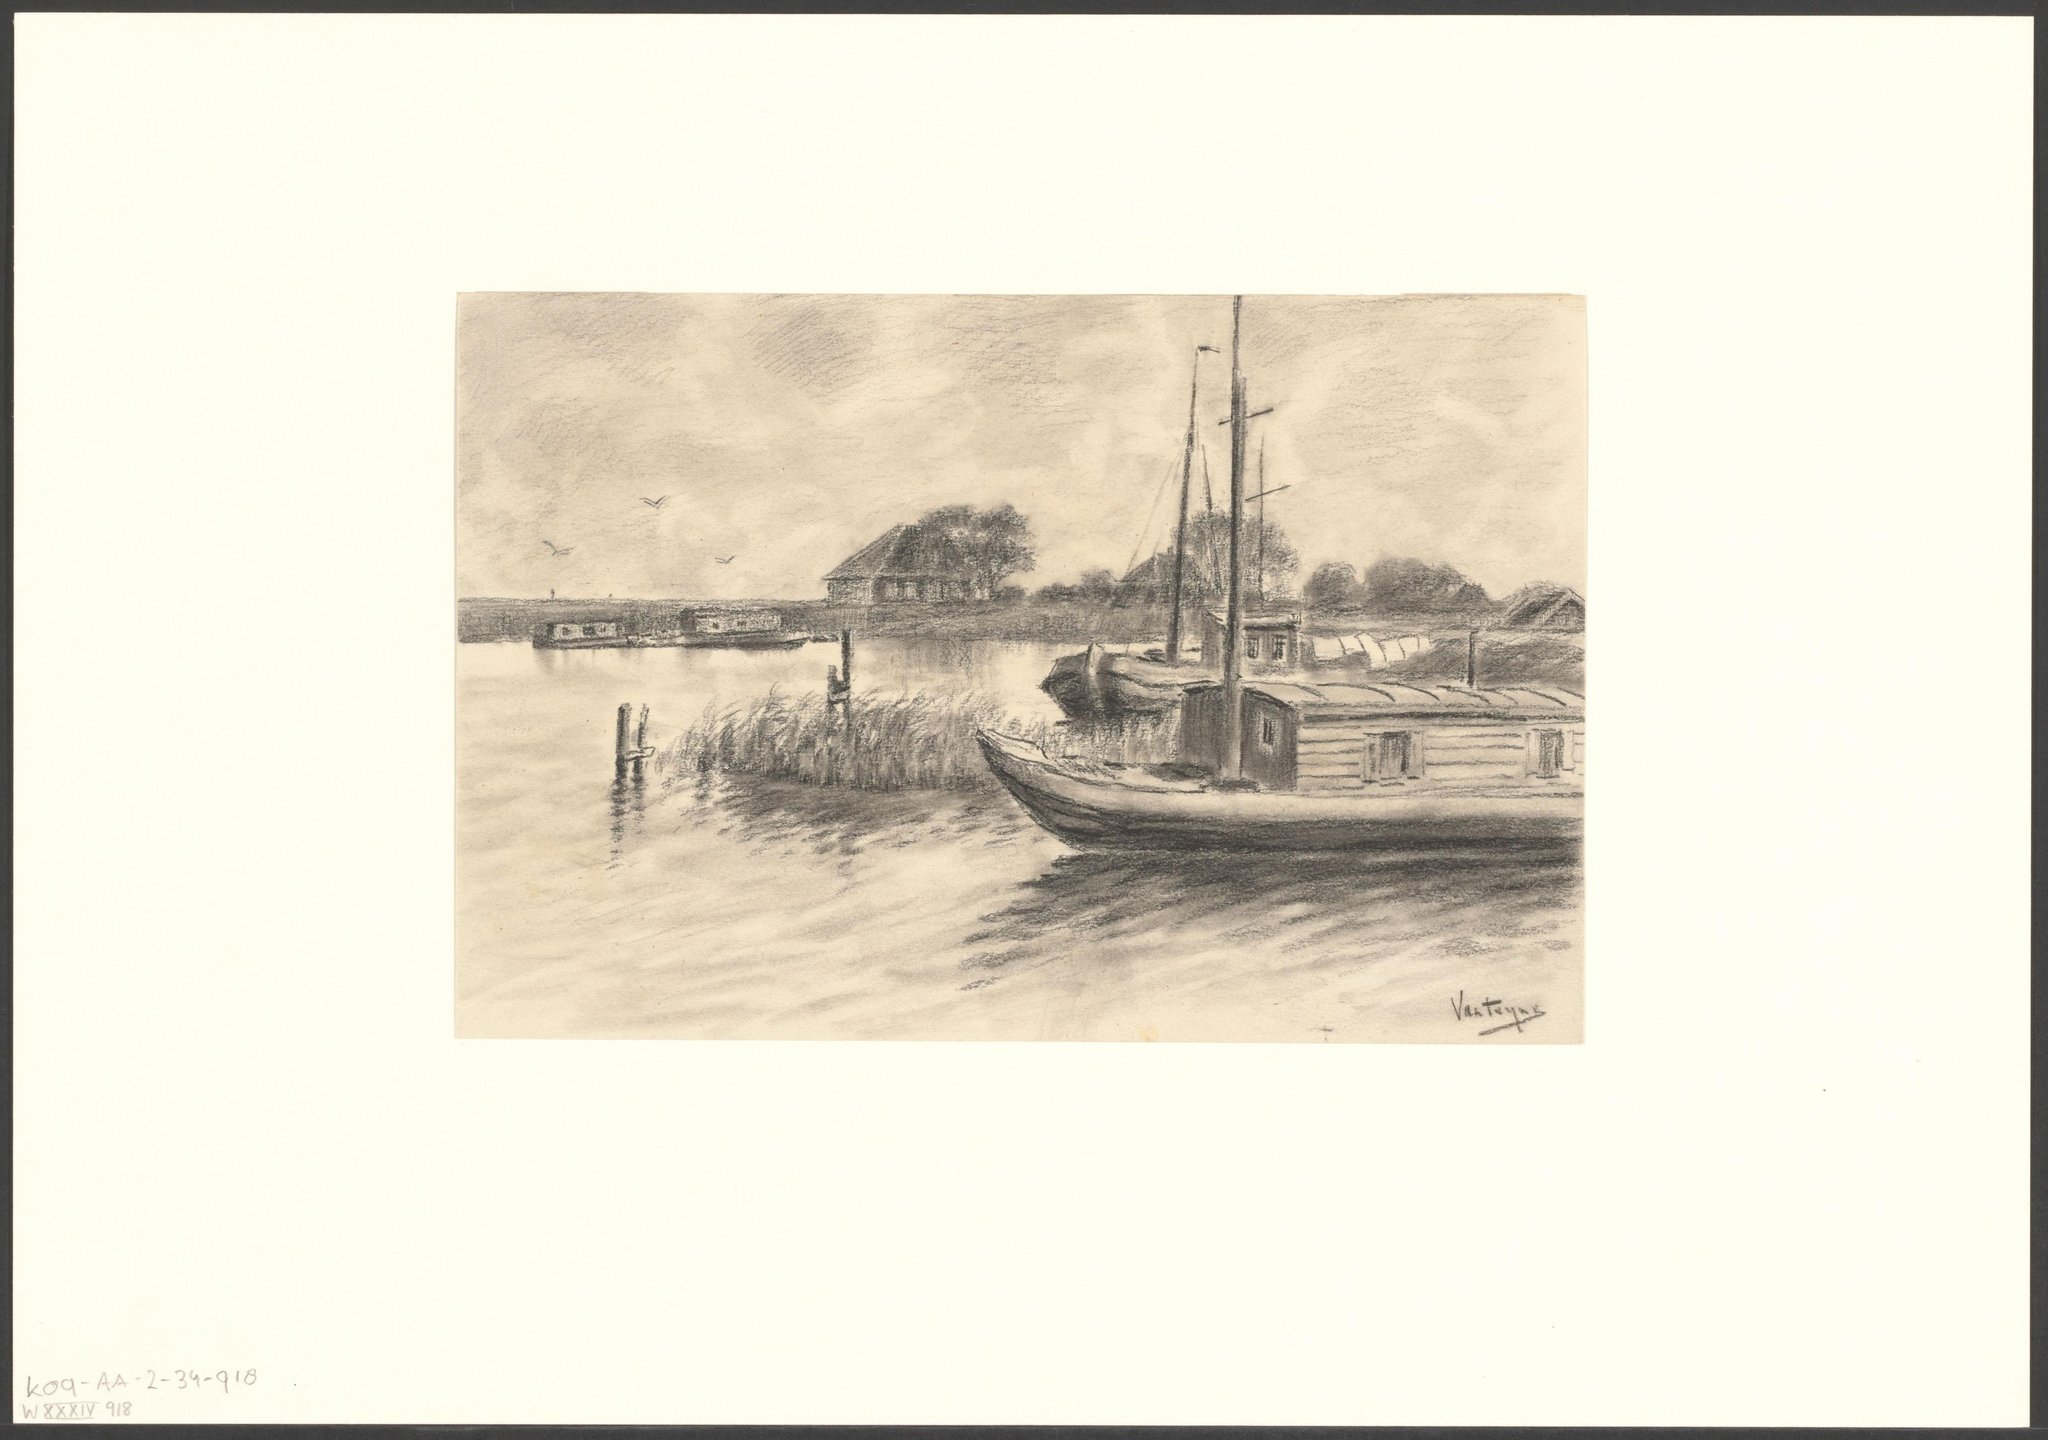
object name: drawing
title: Gezicht op Zijkanaal I bij het Buiksloterkanaal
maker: anthonie van teijn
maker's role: draughtsman, painter, print maker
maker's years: 1863-1943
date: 1909-1927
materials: chalk, paper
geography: amsterdam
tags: city-view in general; 'veduta', canal, farm or solitary house in landscape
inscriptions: inscription: ‘Zijkanaal I bij (...) sept 1927 / vanEck’, collector's mark: Lugt 800a, signature: ‘VanTeyne’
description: Tekening binnen de Atlas Van Eck ingedeeld op wijknummer 34.